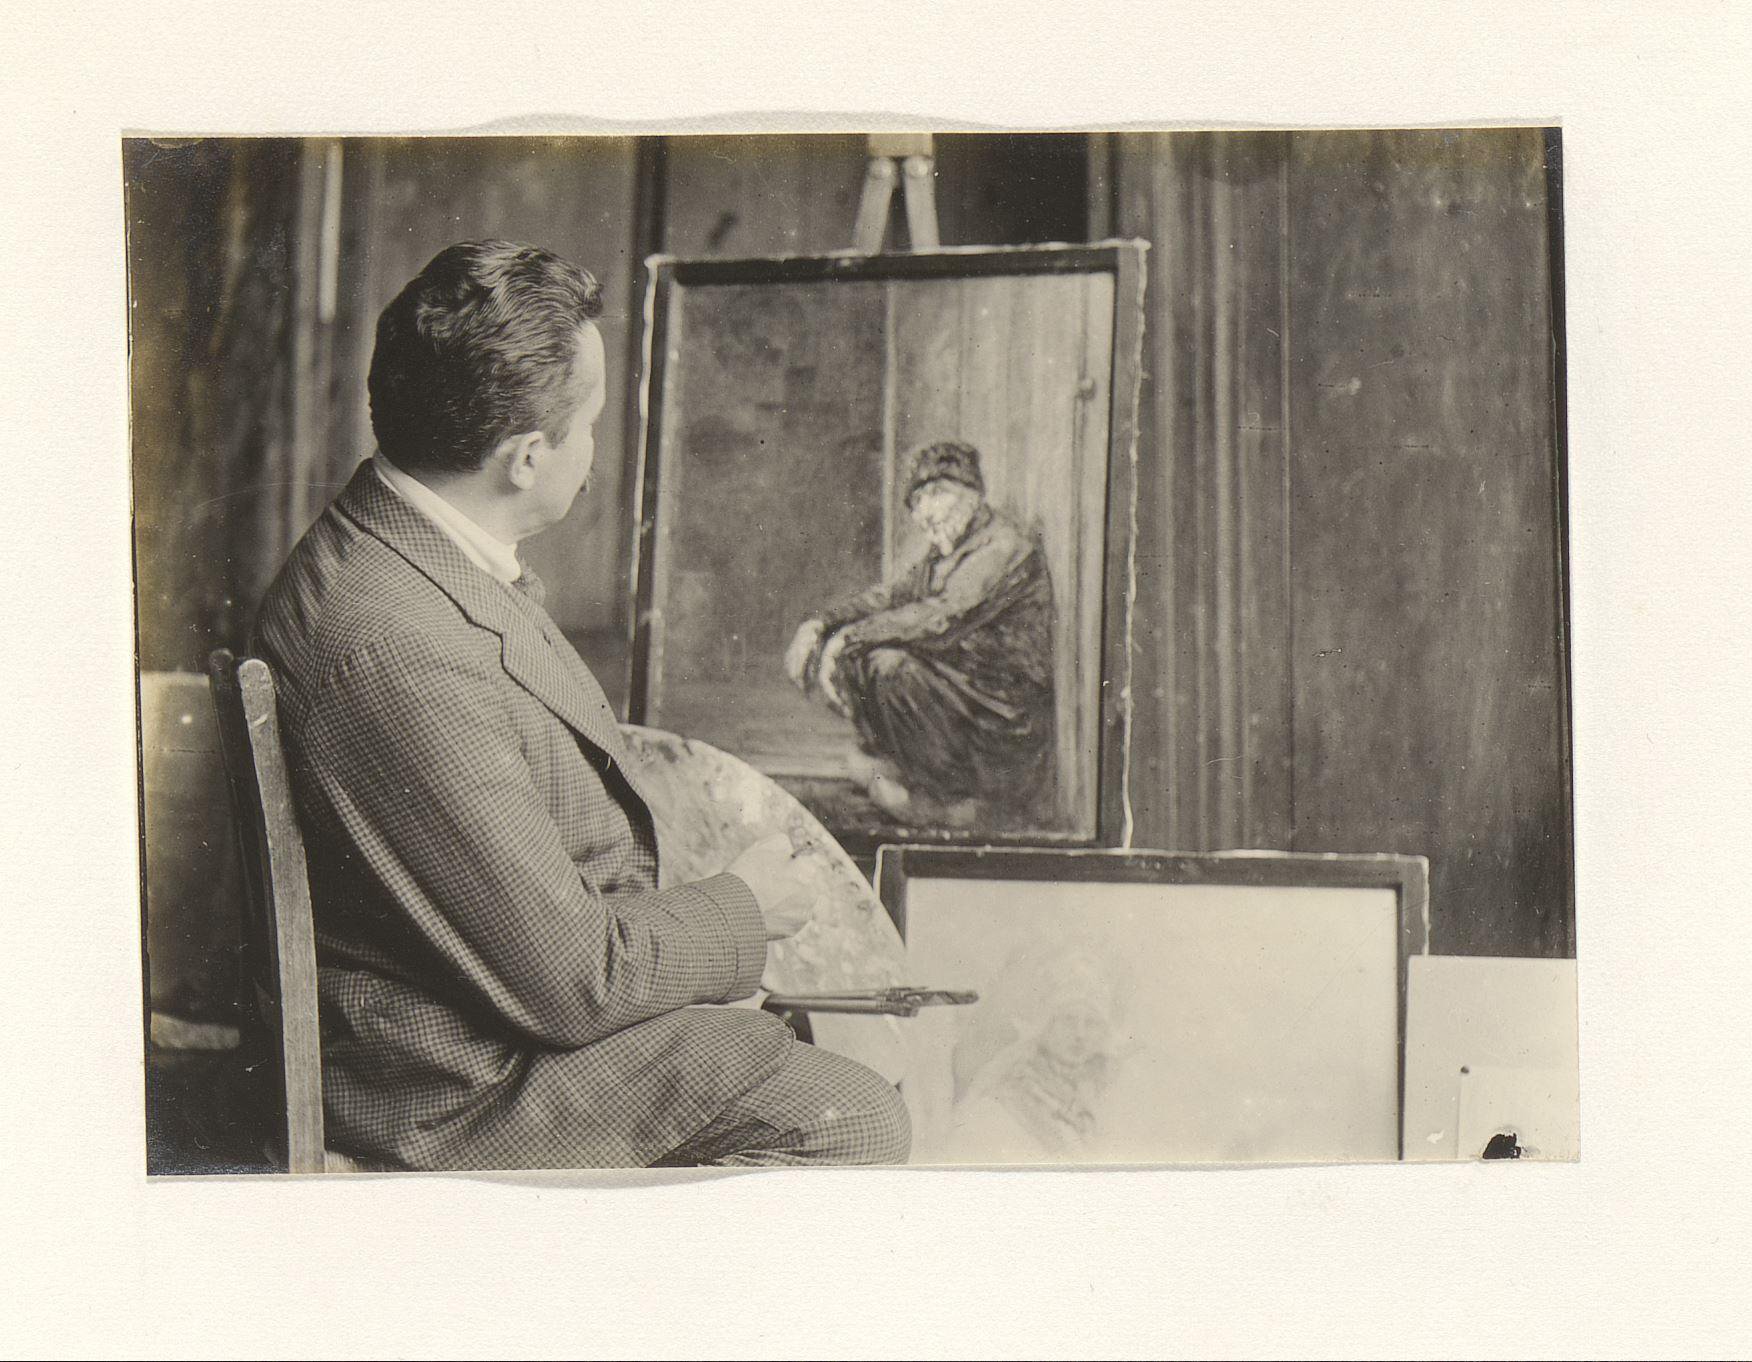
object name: album leaf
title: Man in een schildersatelier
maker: george hidderley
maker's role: fotograaf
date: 1900-1910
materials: paper, photographic support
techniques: gelatin silver print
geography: volendam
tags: adult man, historical persons, workshop, studio ~ painter